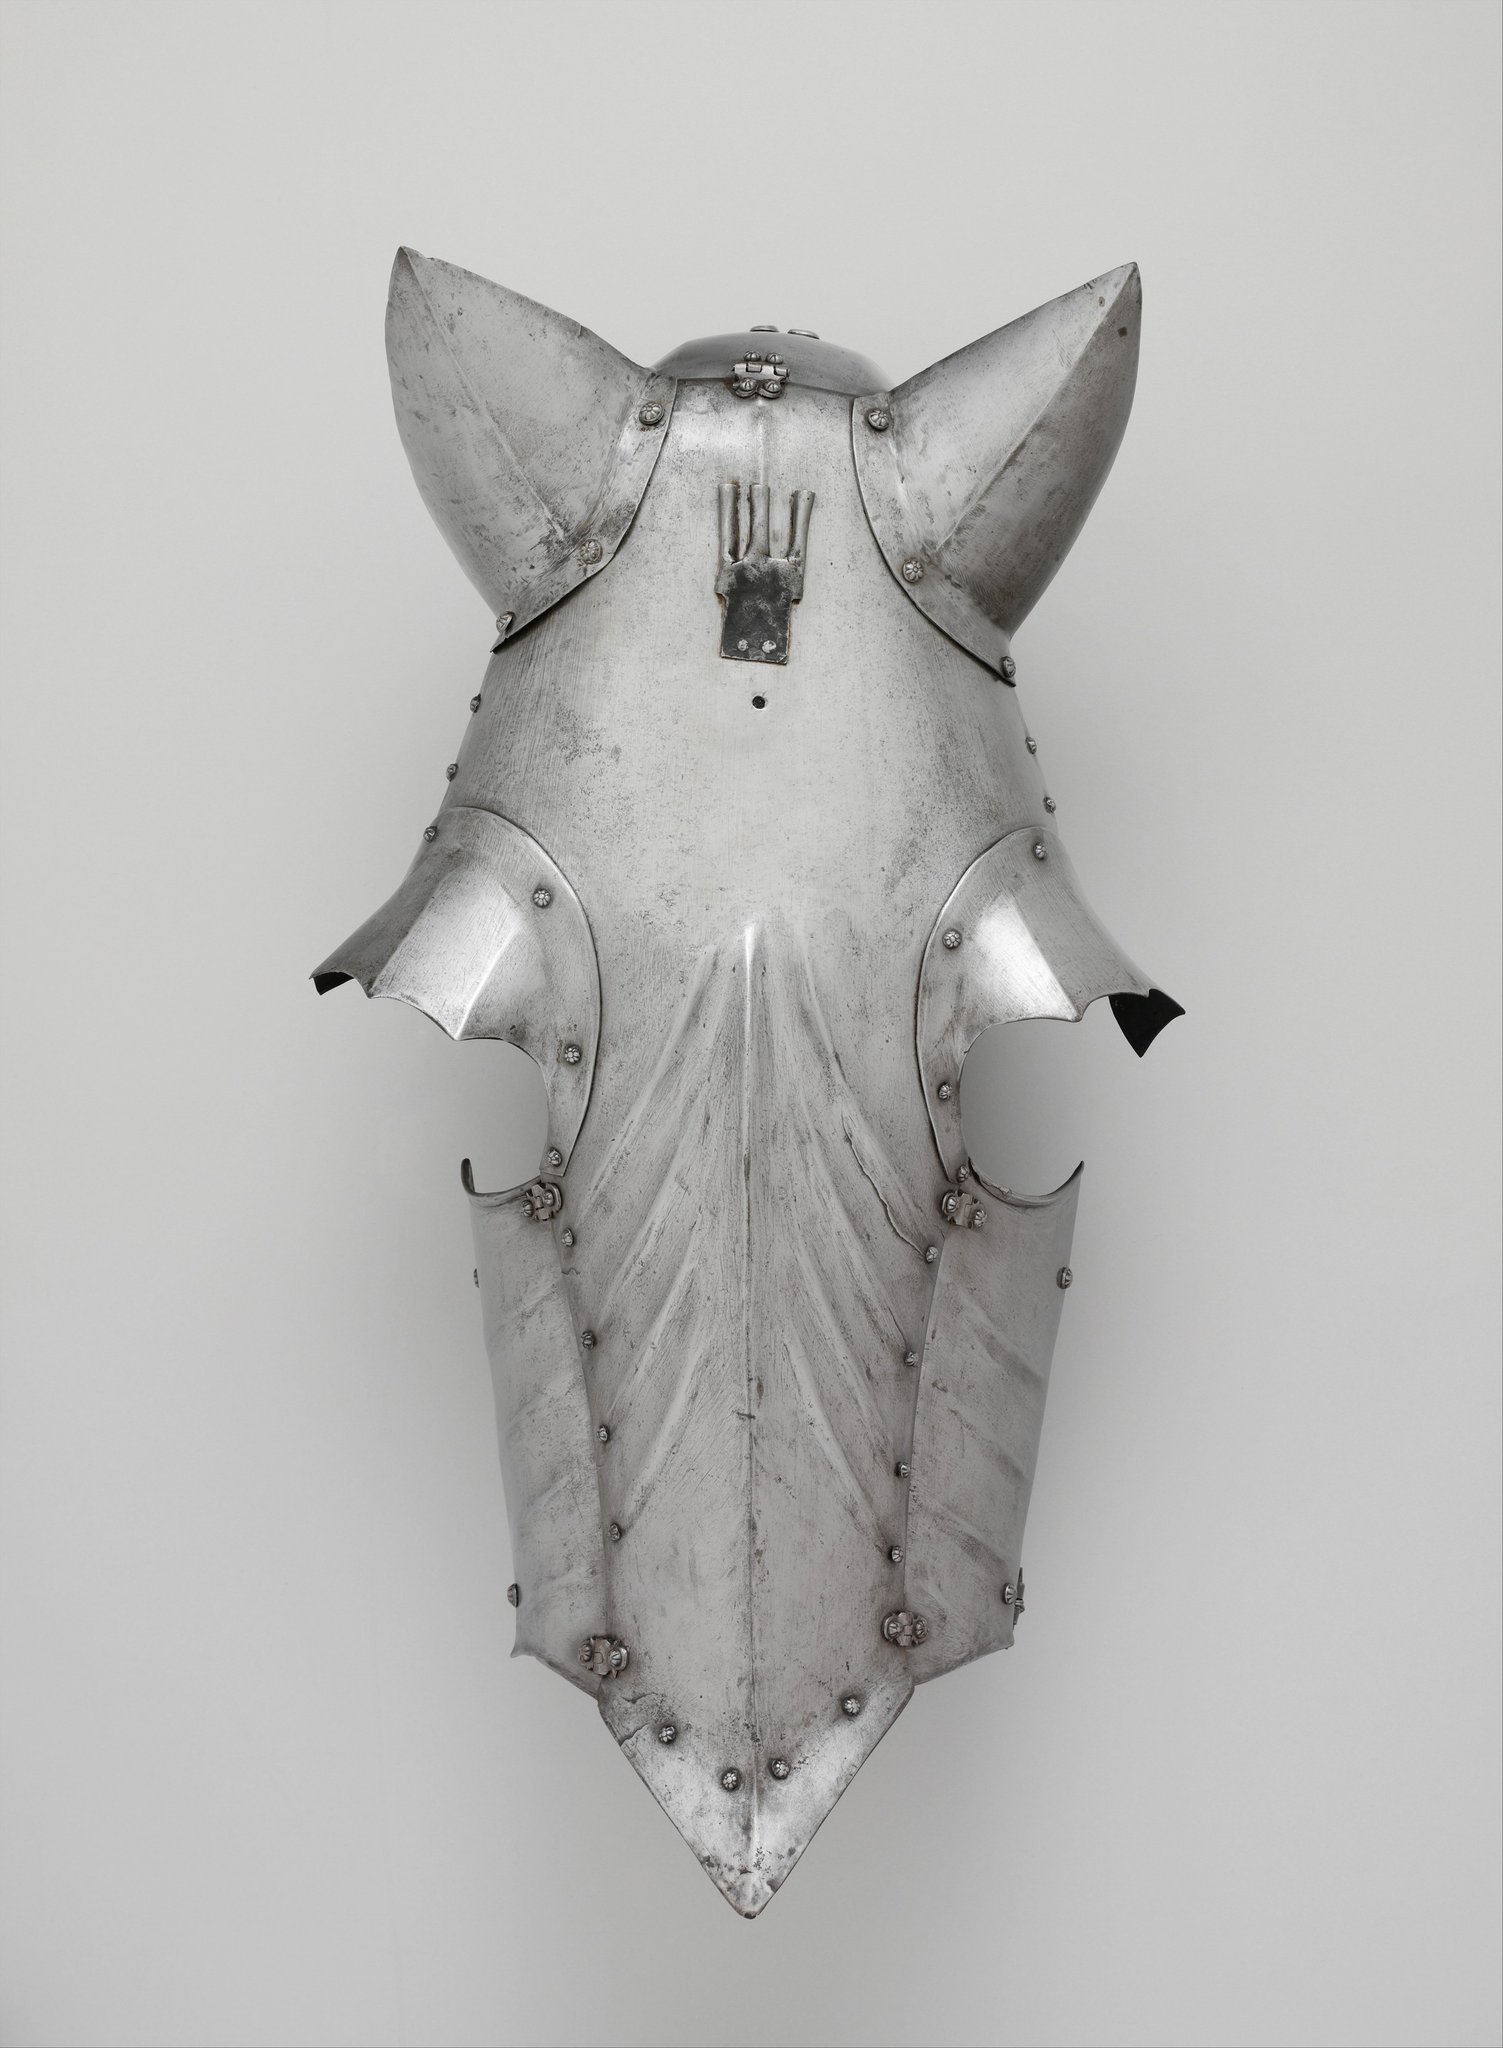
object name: shaffron horse's head defense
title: Shaffron (Horse's Head Defense)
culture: franco-italian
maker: romain des ursins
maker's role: armorer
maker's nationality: italian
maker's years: 1493-1495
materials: steel, textile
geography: france or italy